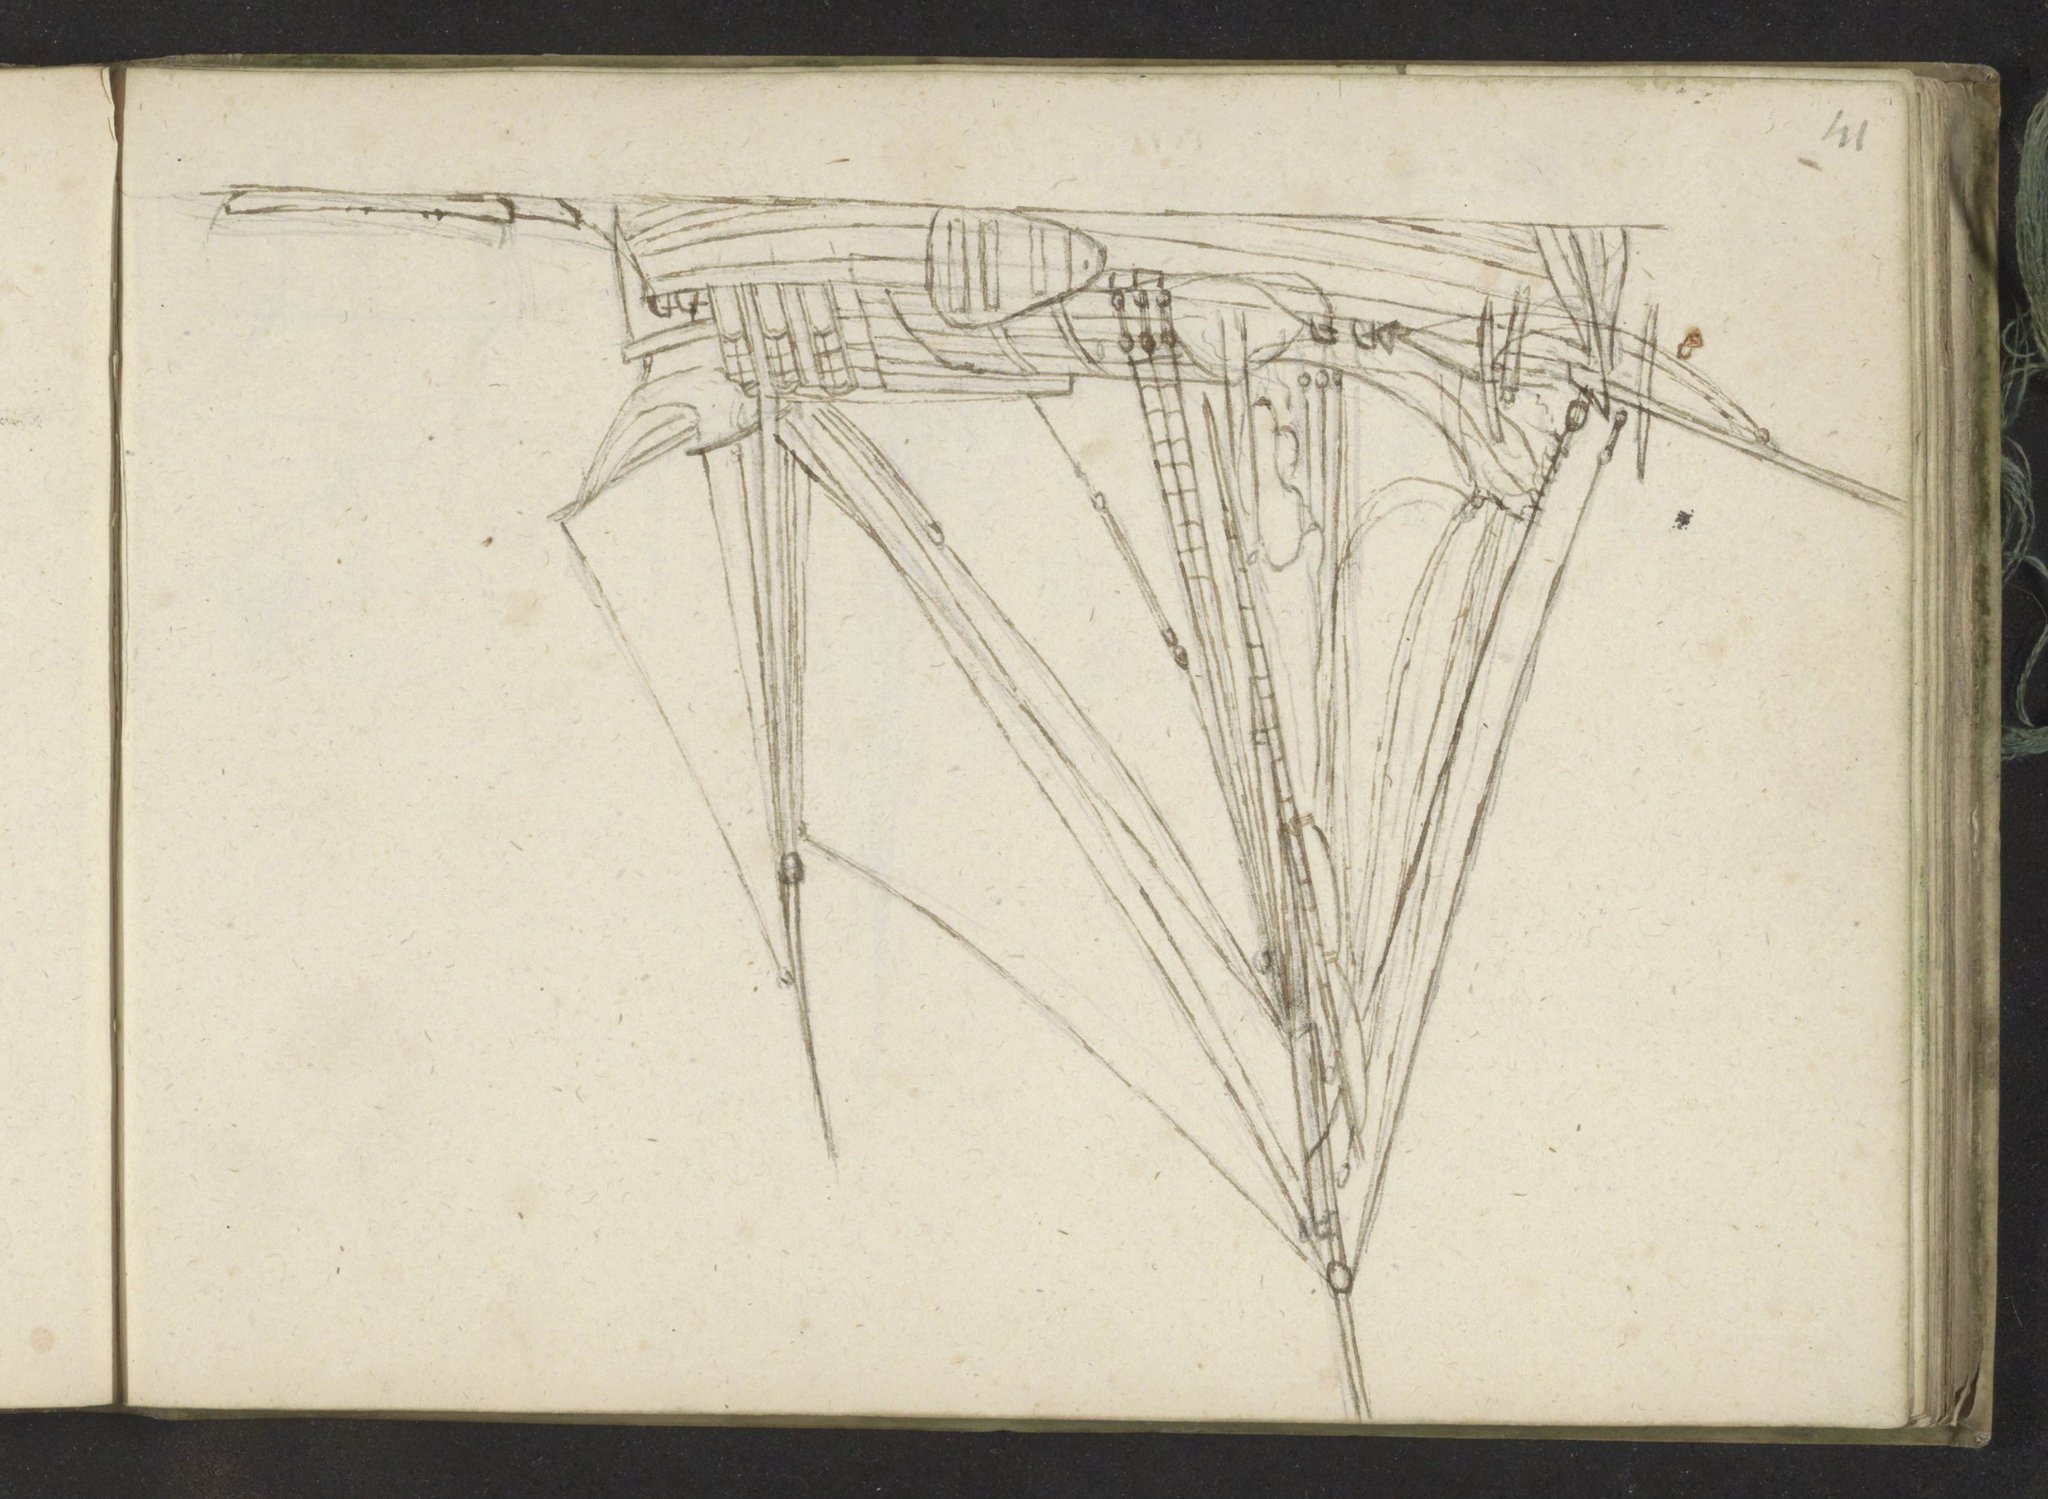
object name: sketchbook leaf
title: Zeilschip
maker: martinus schouman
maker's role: draughtsman, painter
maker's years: 1770-1848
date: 1780-1848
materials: ink, paper, pencil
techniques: pen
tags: sailing-ship, sailing-boat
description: Blad 41 recto uit een schetsboek met 53 bladen.